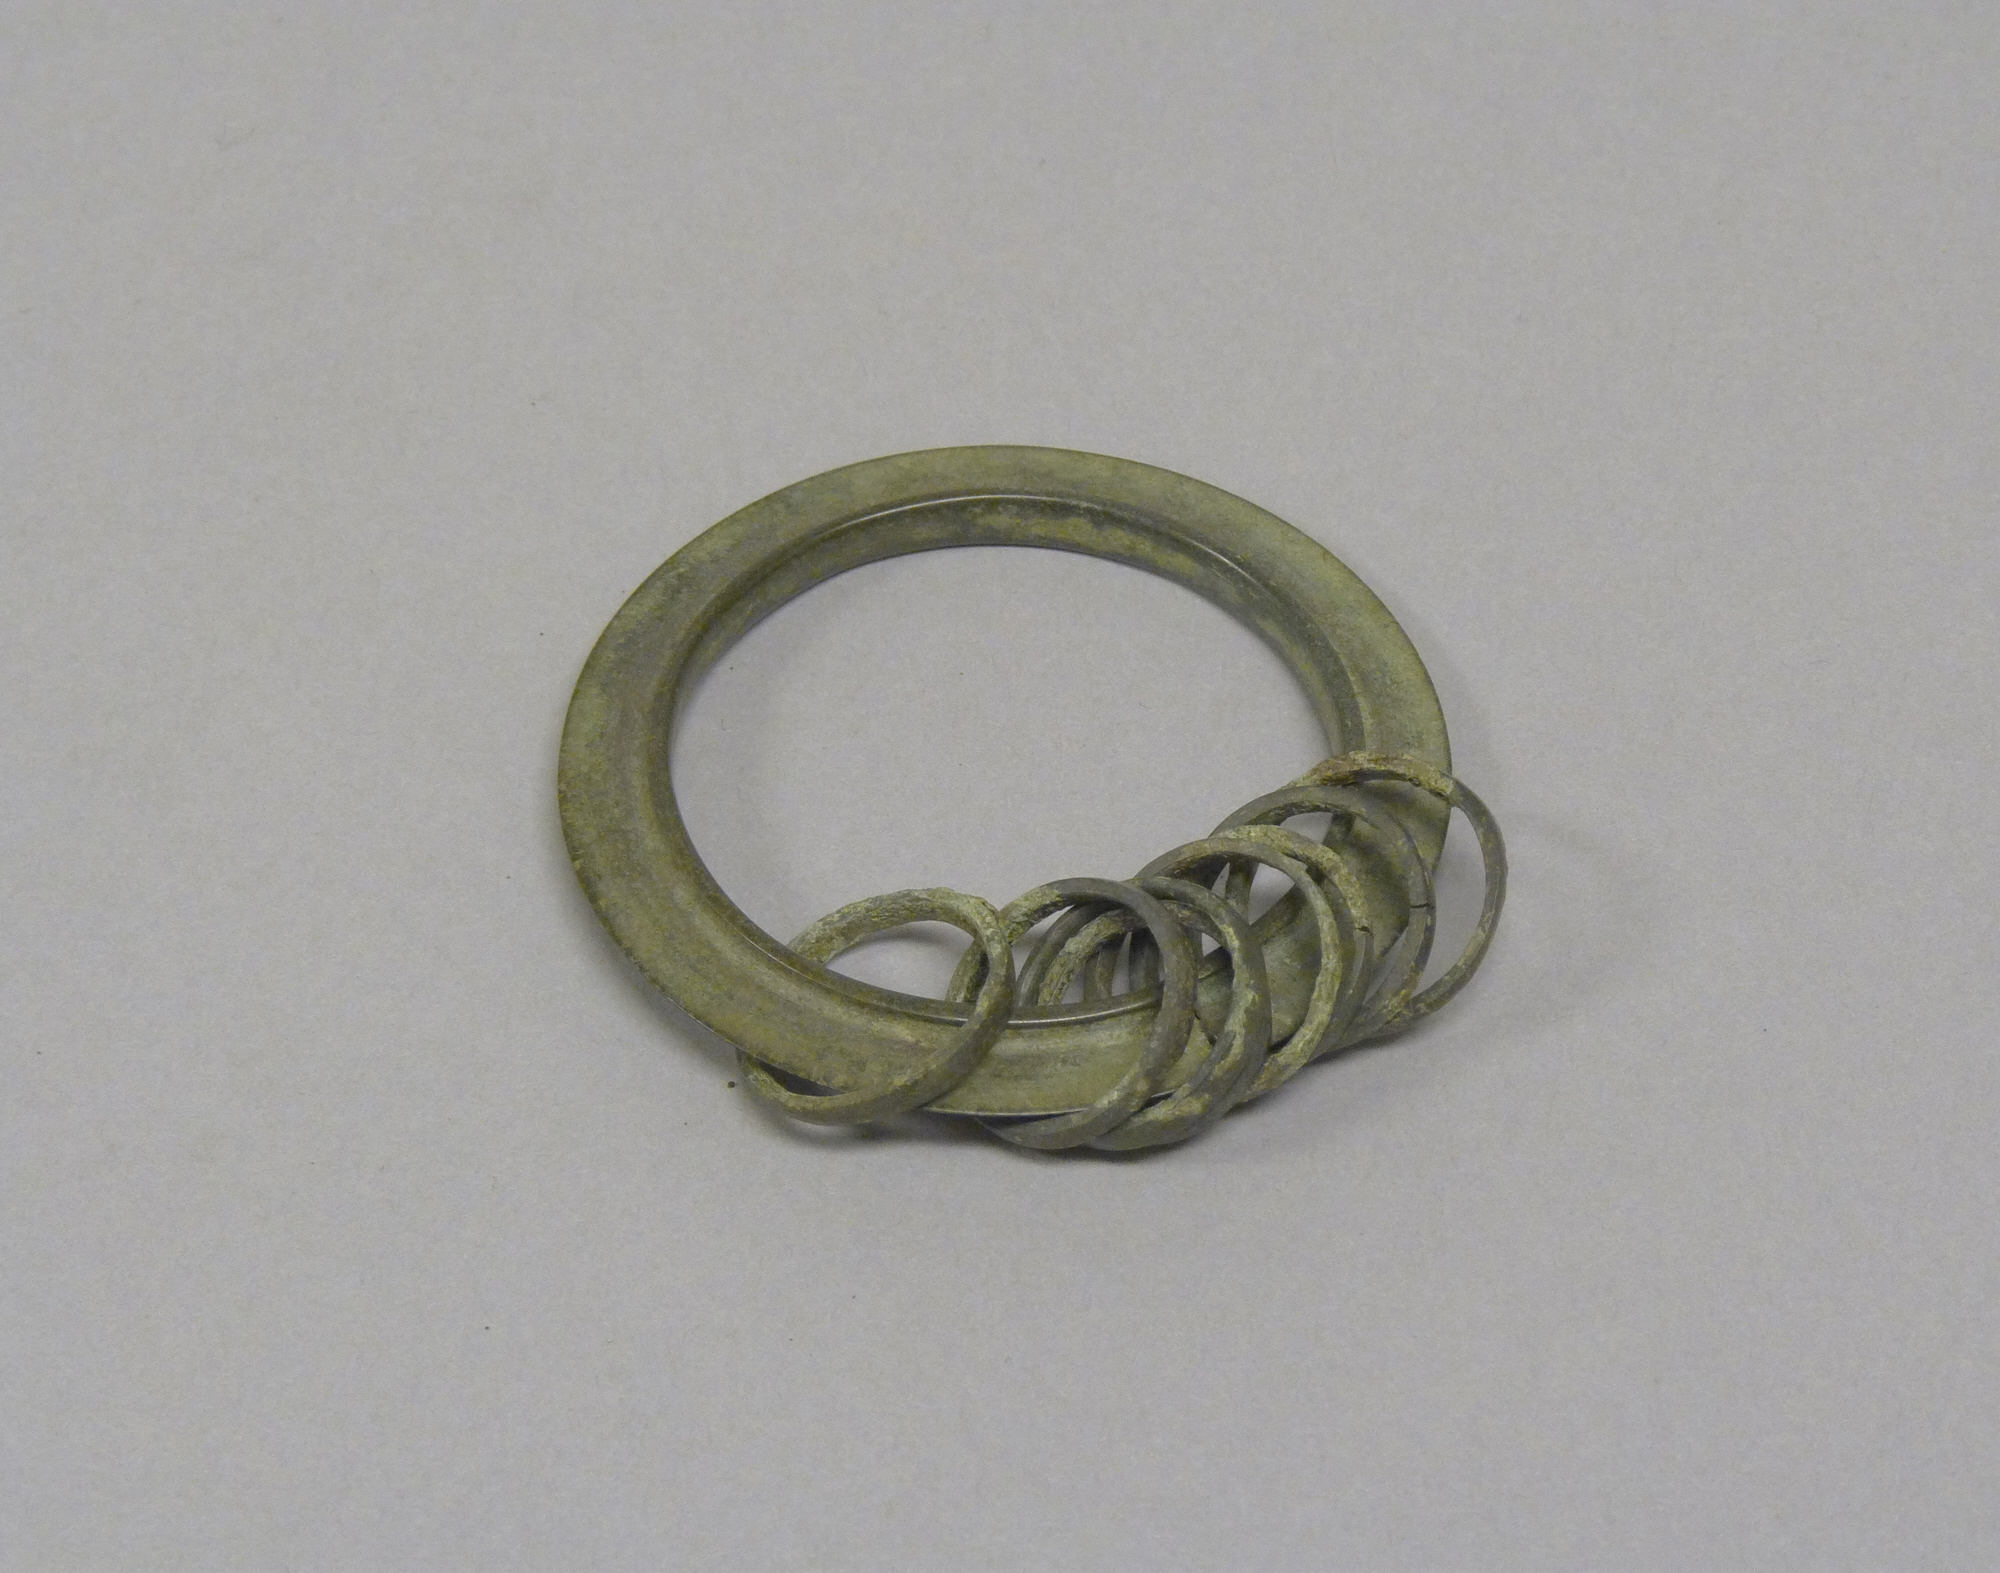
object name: bangle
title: Bangle with Rings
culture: thai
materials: bronze